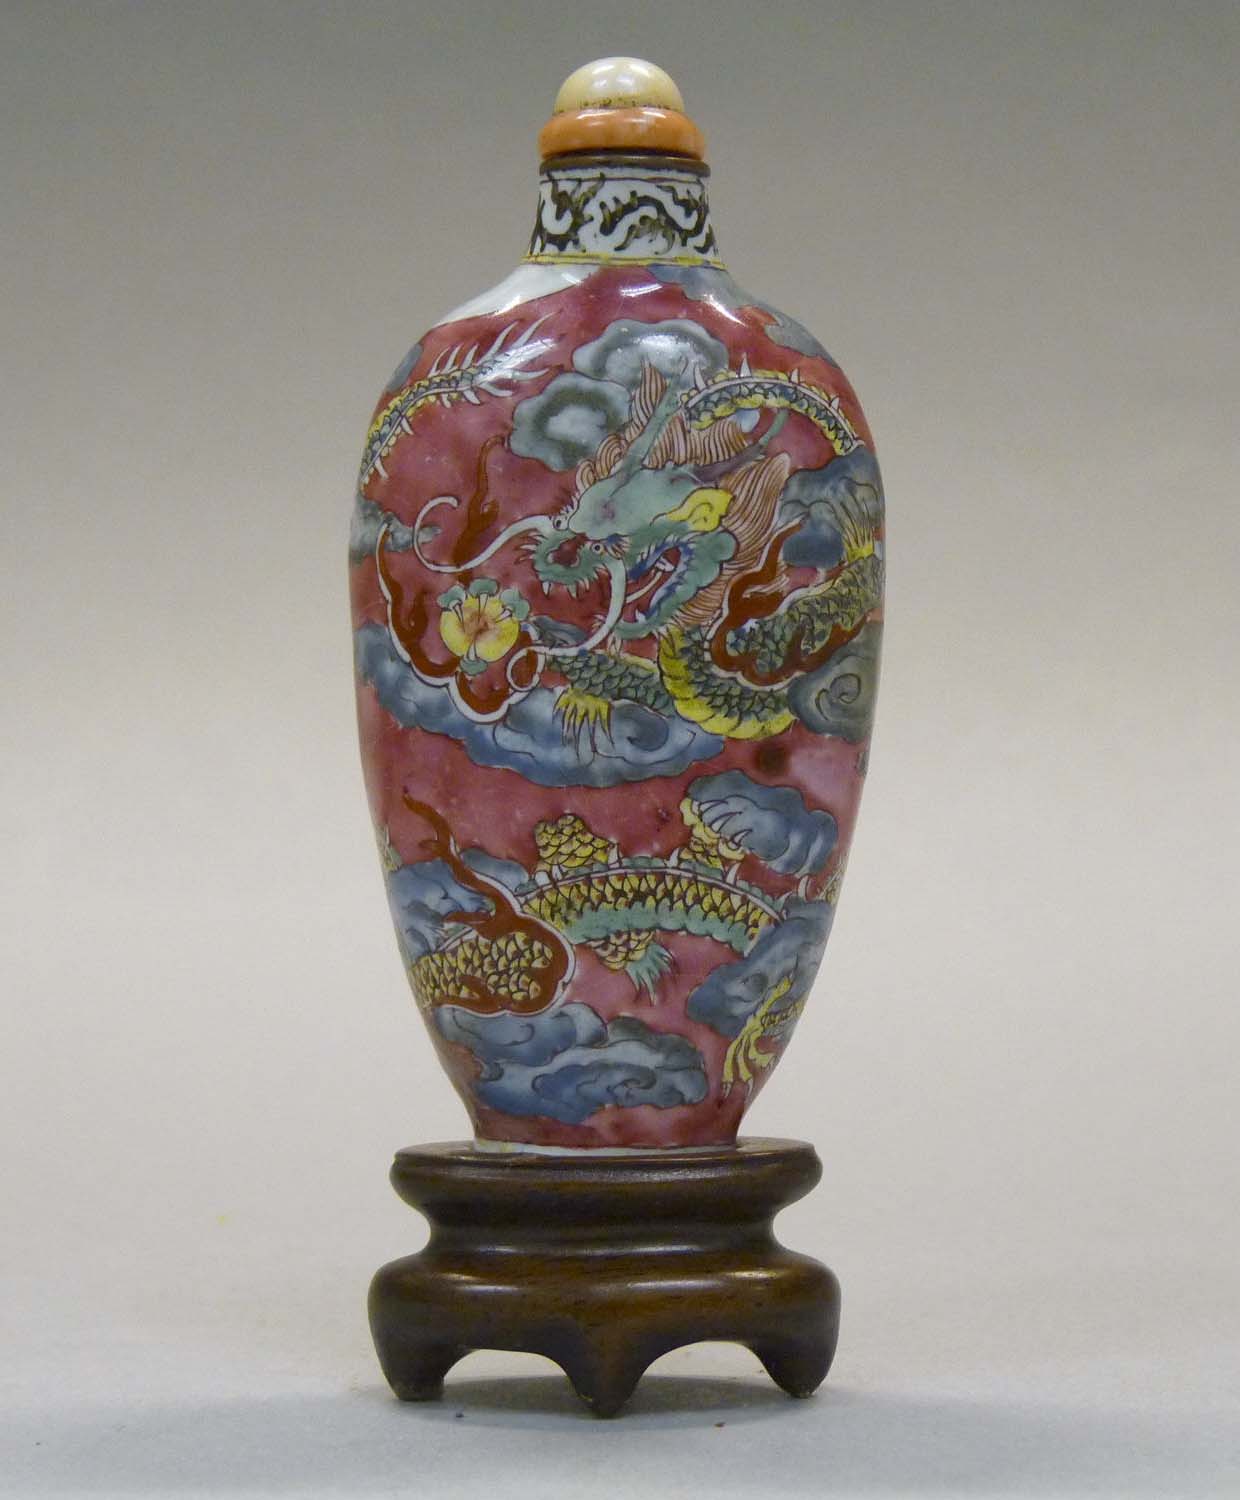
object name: snuff bottle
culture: chinese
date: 1801-1900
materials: coral, enamel, pearl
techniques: painting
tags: dragons